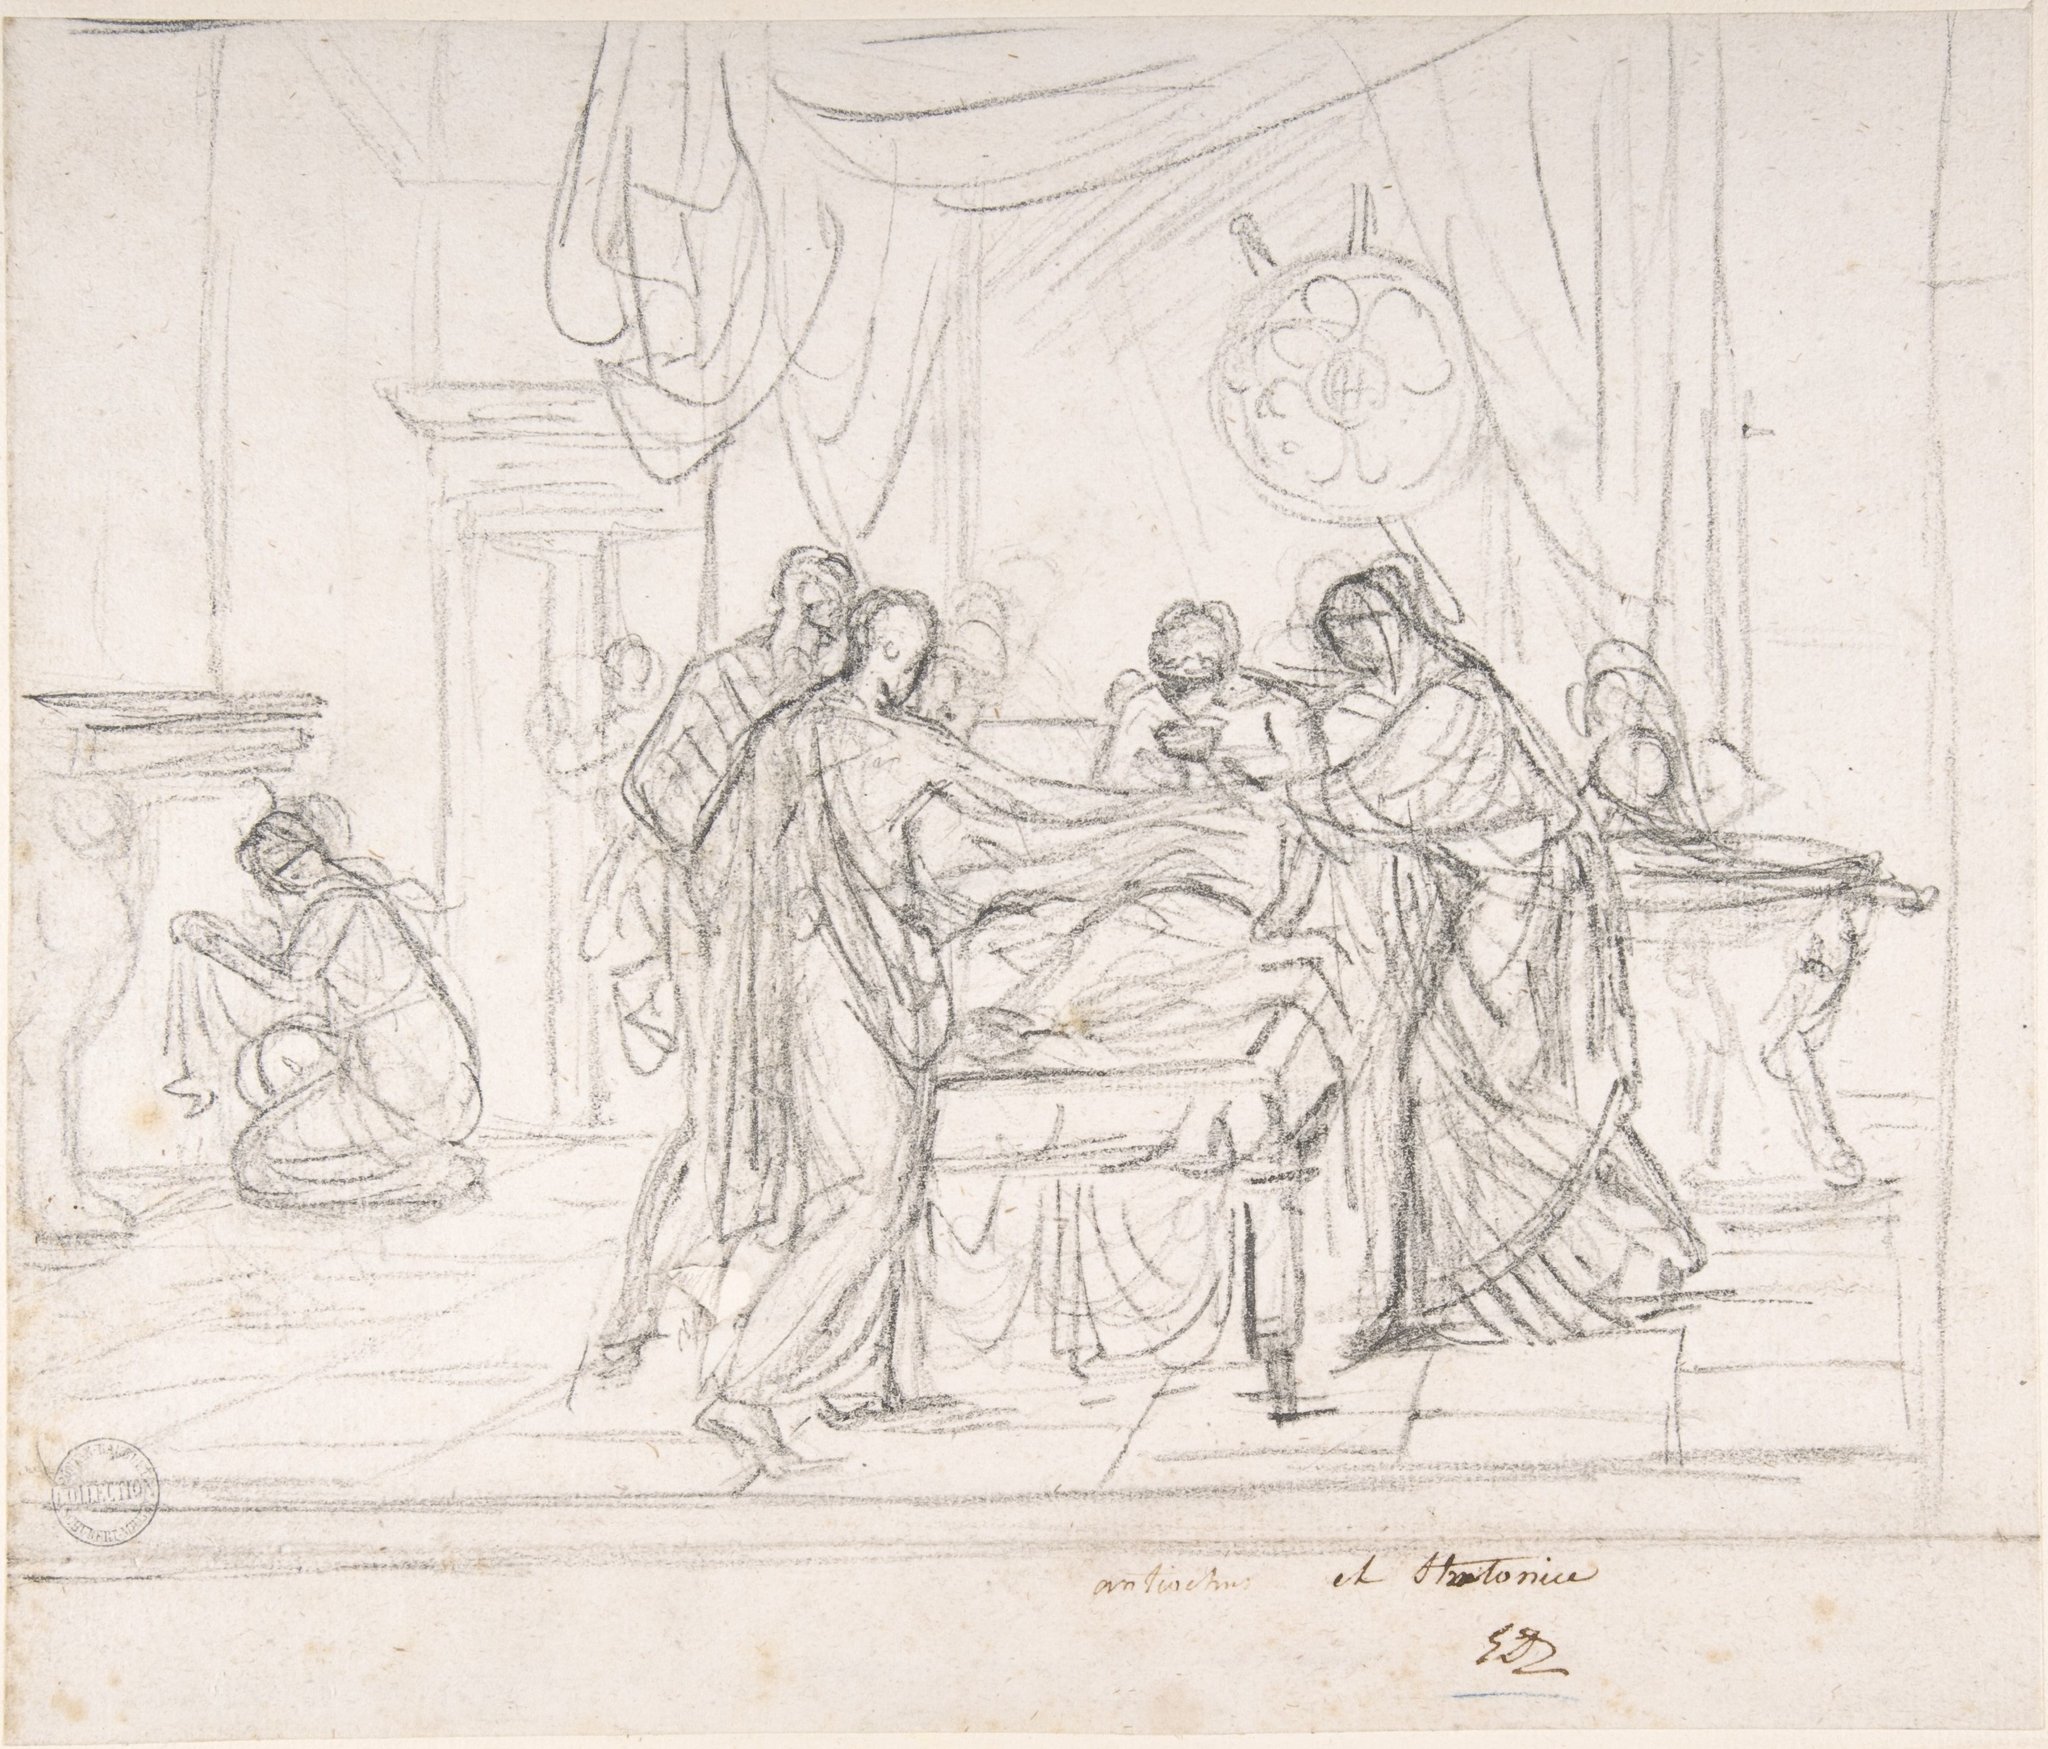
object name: drawing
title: Scene from Ancient History: Cup Offered to an Invalid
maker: jacques louis david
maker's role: artist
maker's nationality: french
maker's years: 1748-1825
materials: chalk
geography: france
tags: shields,men,women,cups